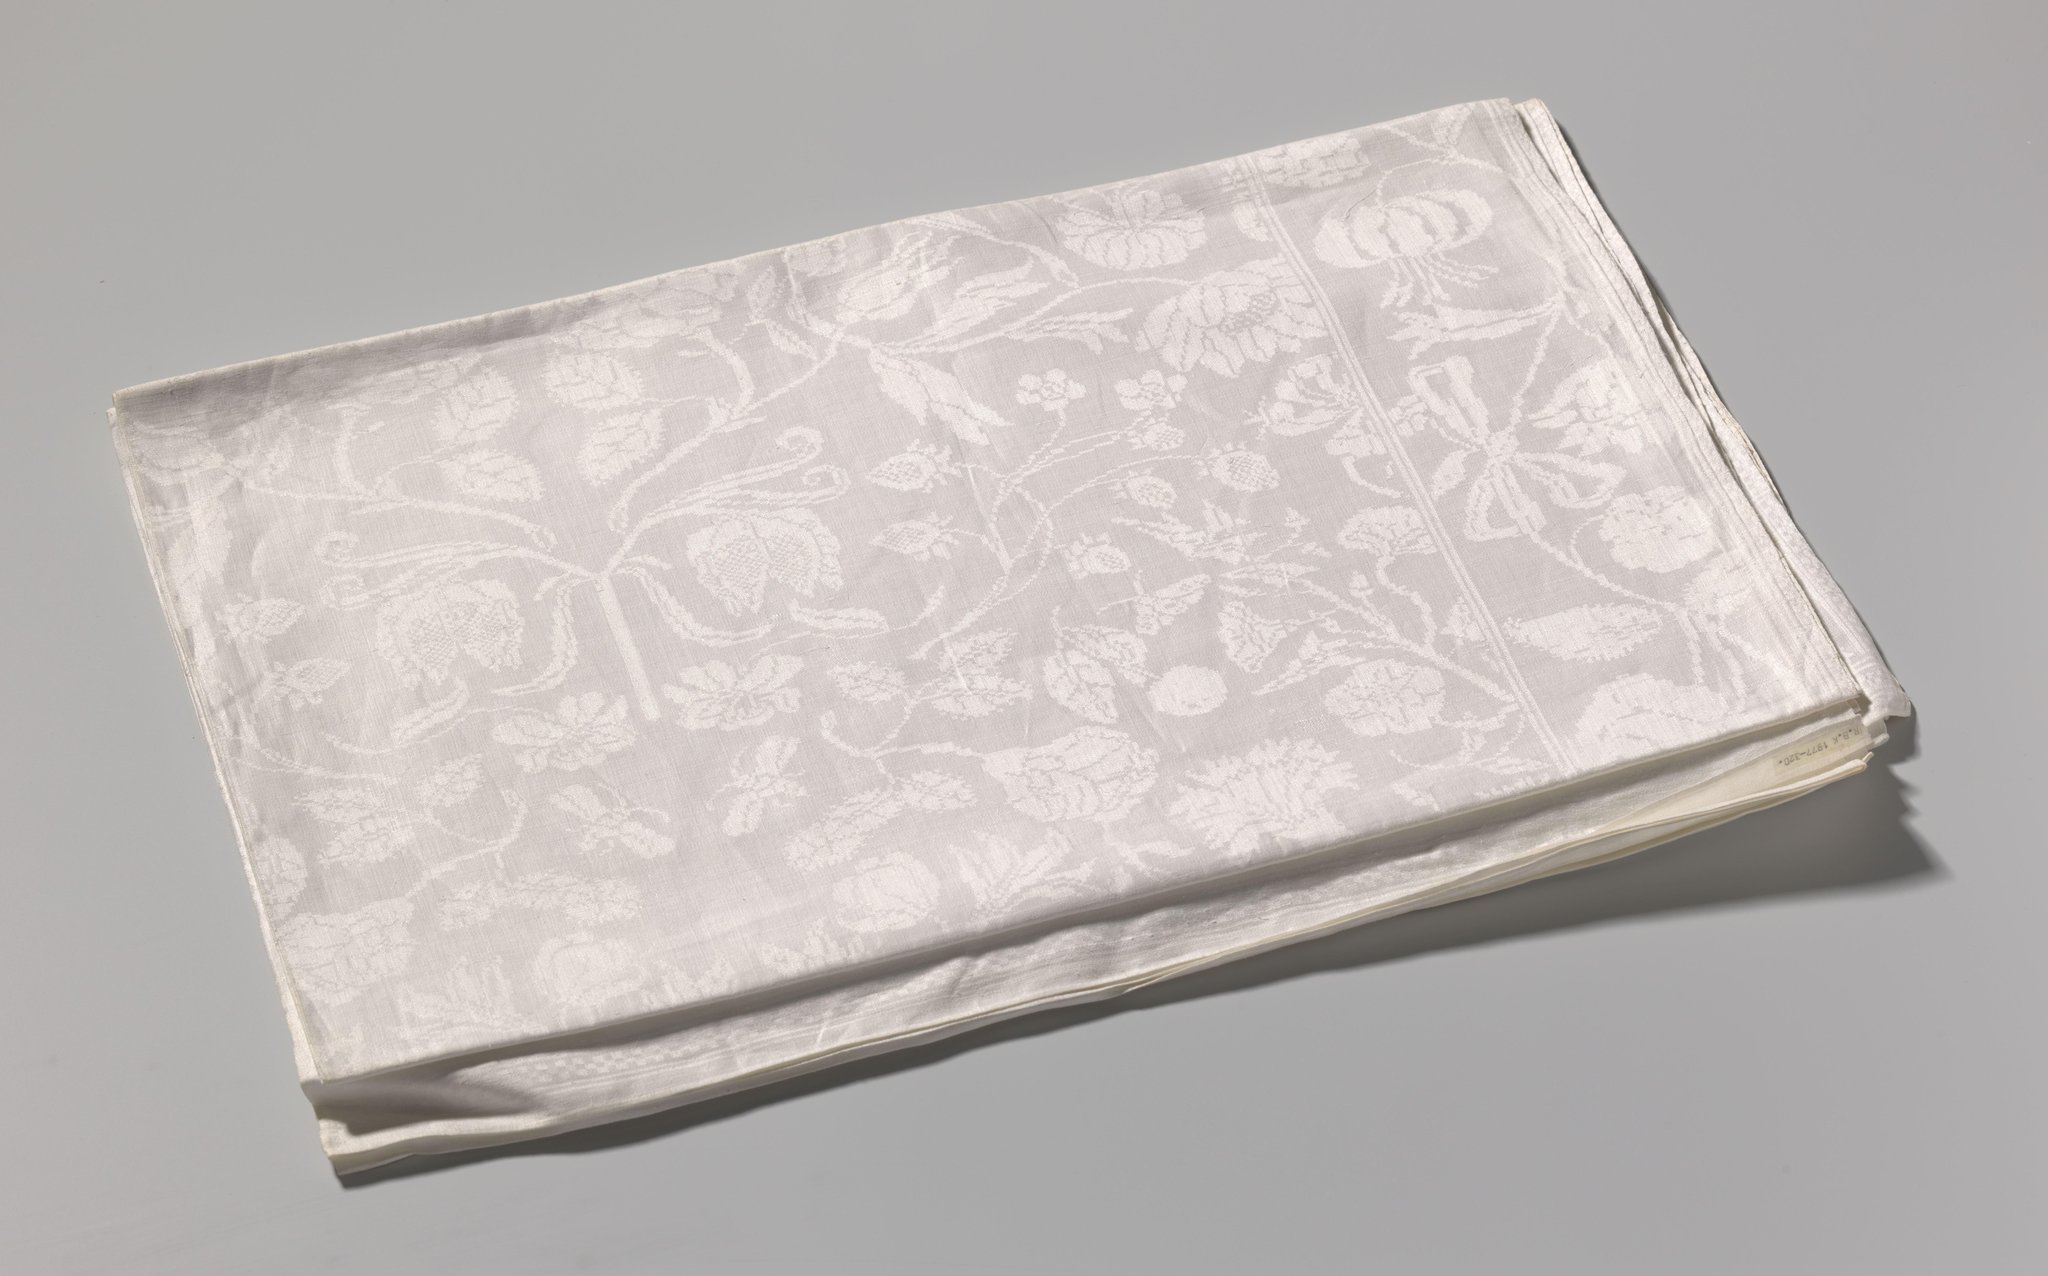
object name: tablecloth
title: Gestrooide bloemen, bloemtakken en vruchten. Merk: kroon H2.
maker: Anonymous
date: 1660-1670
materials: linen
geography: northern netherlands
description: Tafellaken van wit linnen met een patroon van gestrooide bloemen, bloemtakken en vruchten, merk kroon H 2